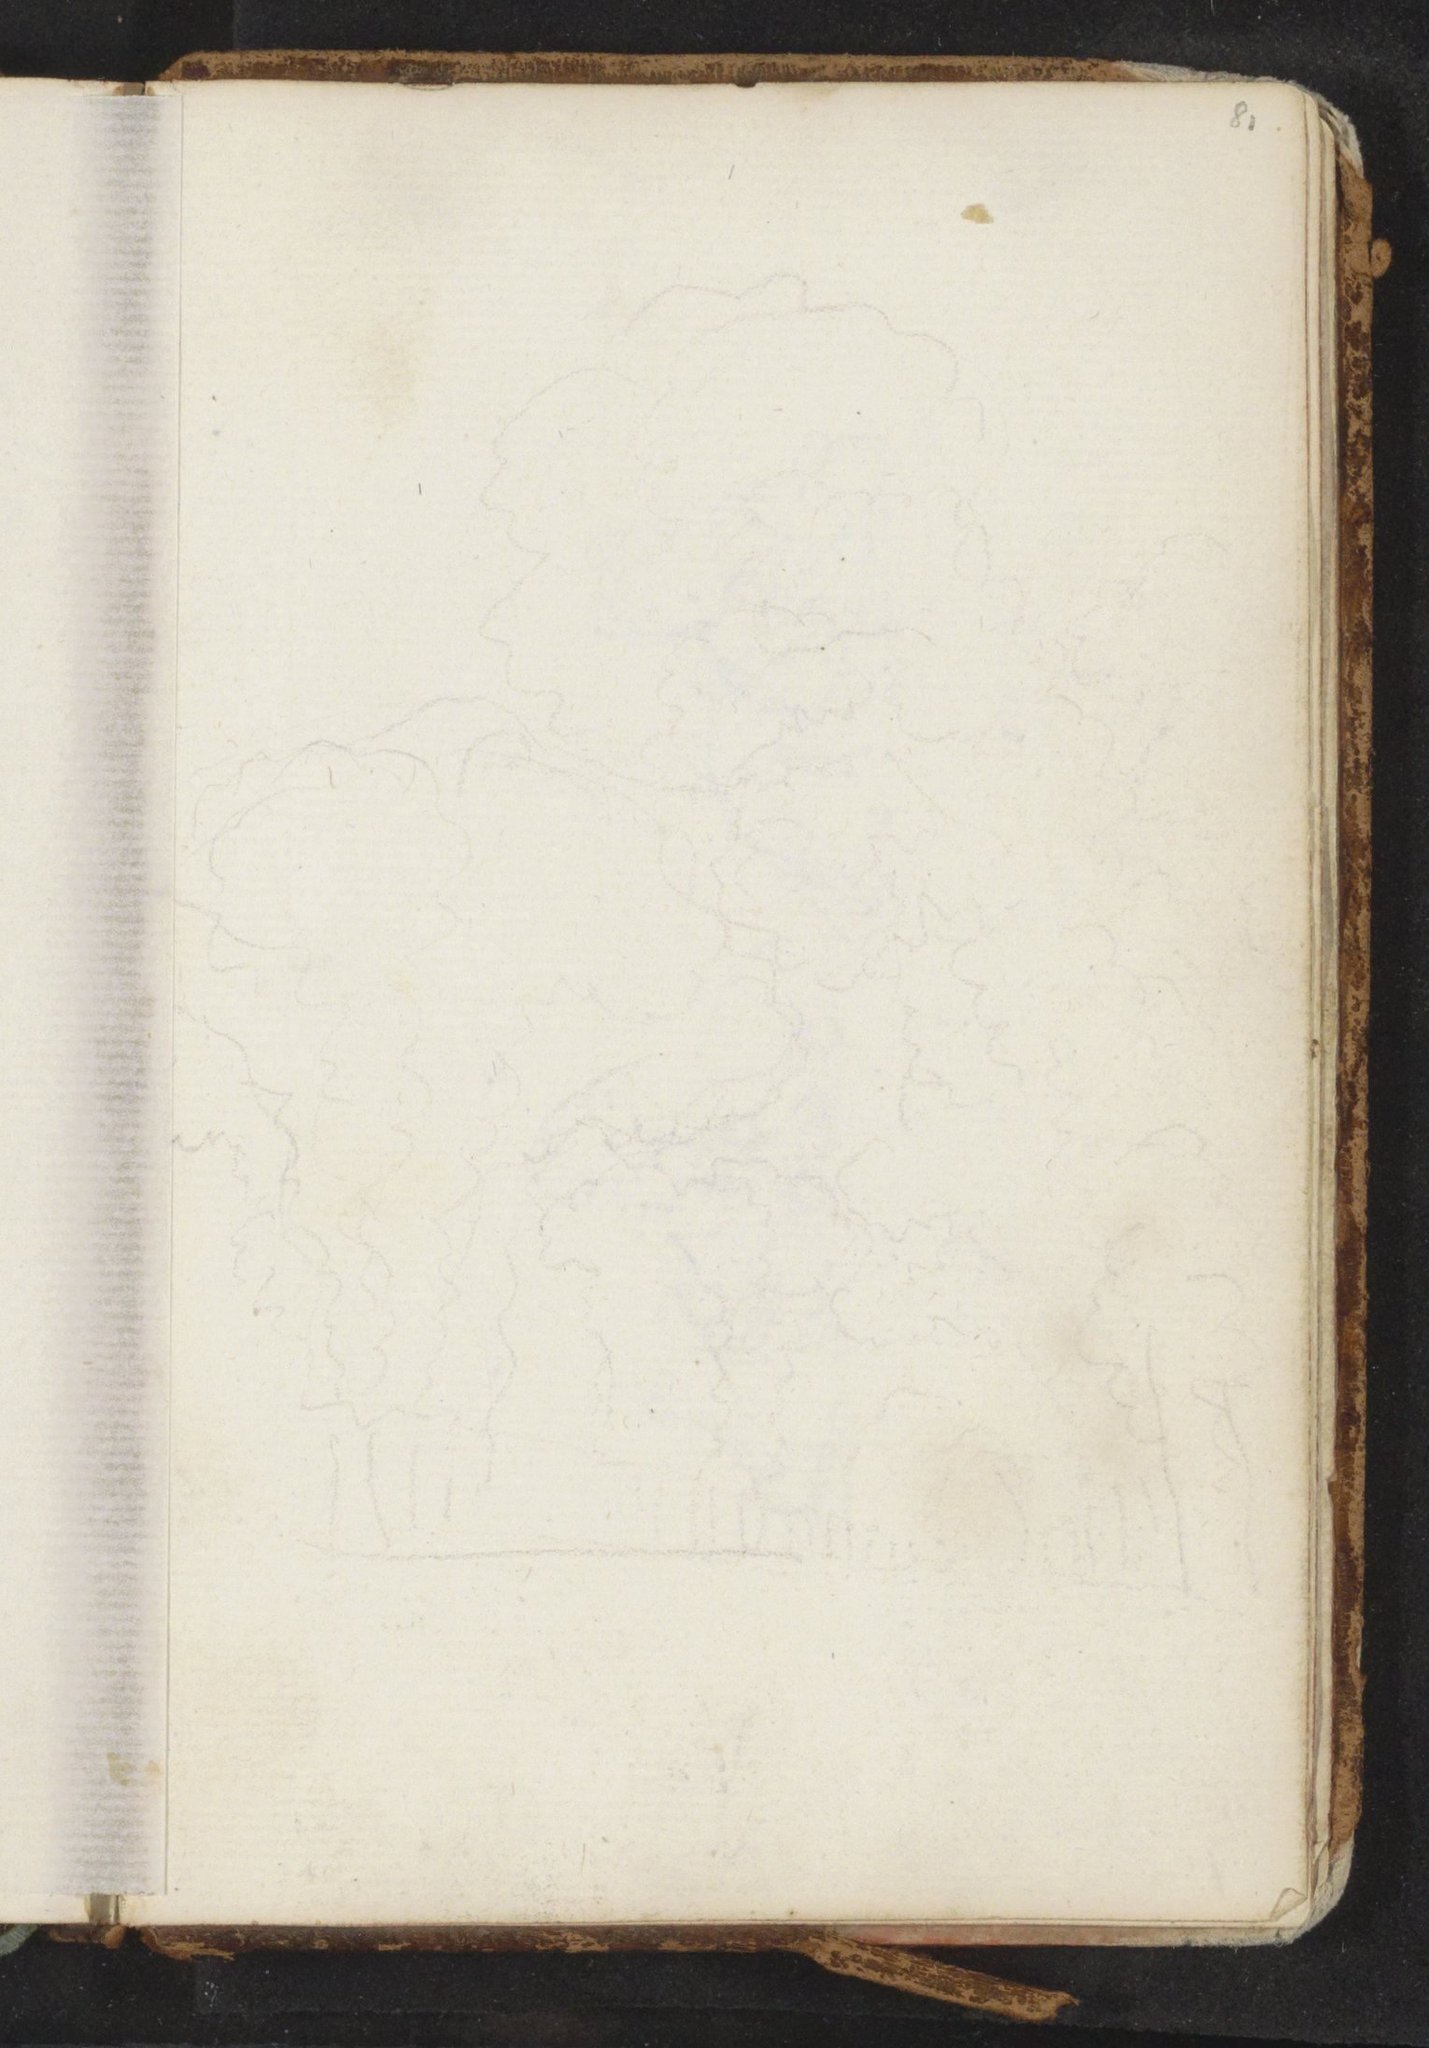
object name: sketchbook leaf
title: Bomen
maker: jean honoré fragonard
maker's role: draughtsman, painter, print maker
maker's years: 1732-1806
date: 1765-1775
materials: paper, pencil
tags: trees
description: Blad 81 recto uit een schetsboek met 83 bladen.